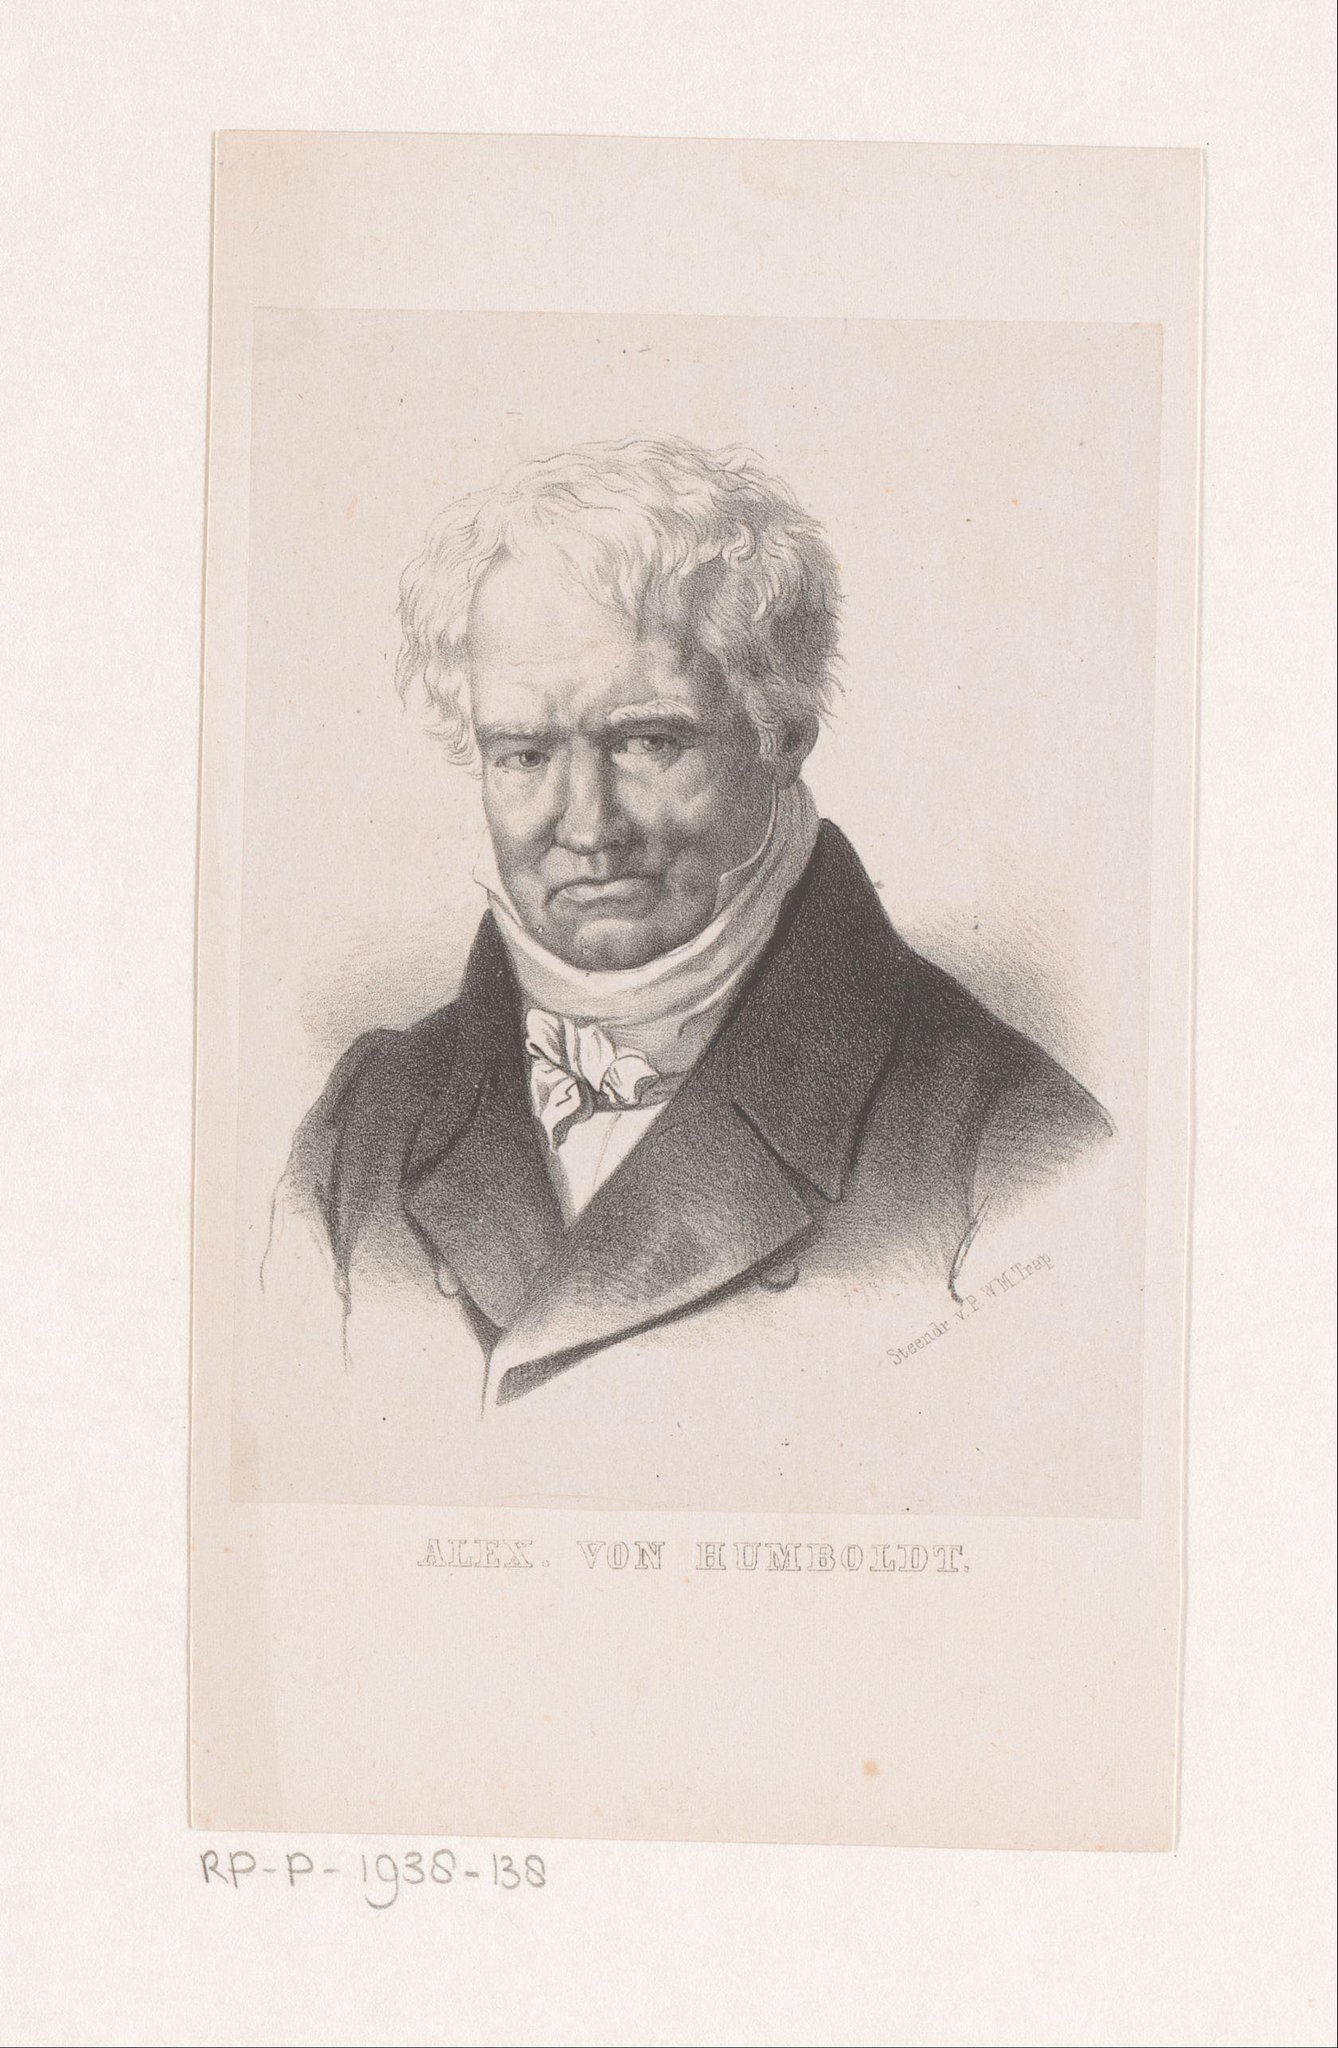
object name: print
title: Portret van Alexander von Humboldt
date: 1836-1905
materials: paper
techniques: lithograph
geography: leiden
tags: berlin, traveler, historical persons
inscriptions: collector's mark: Lugt 2228